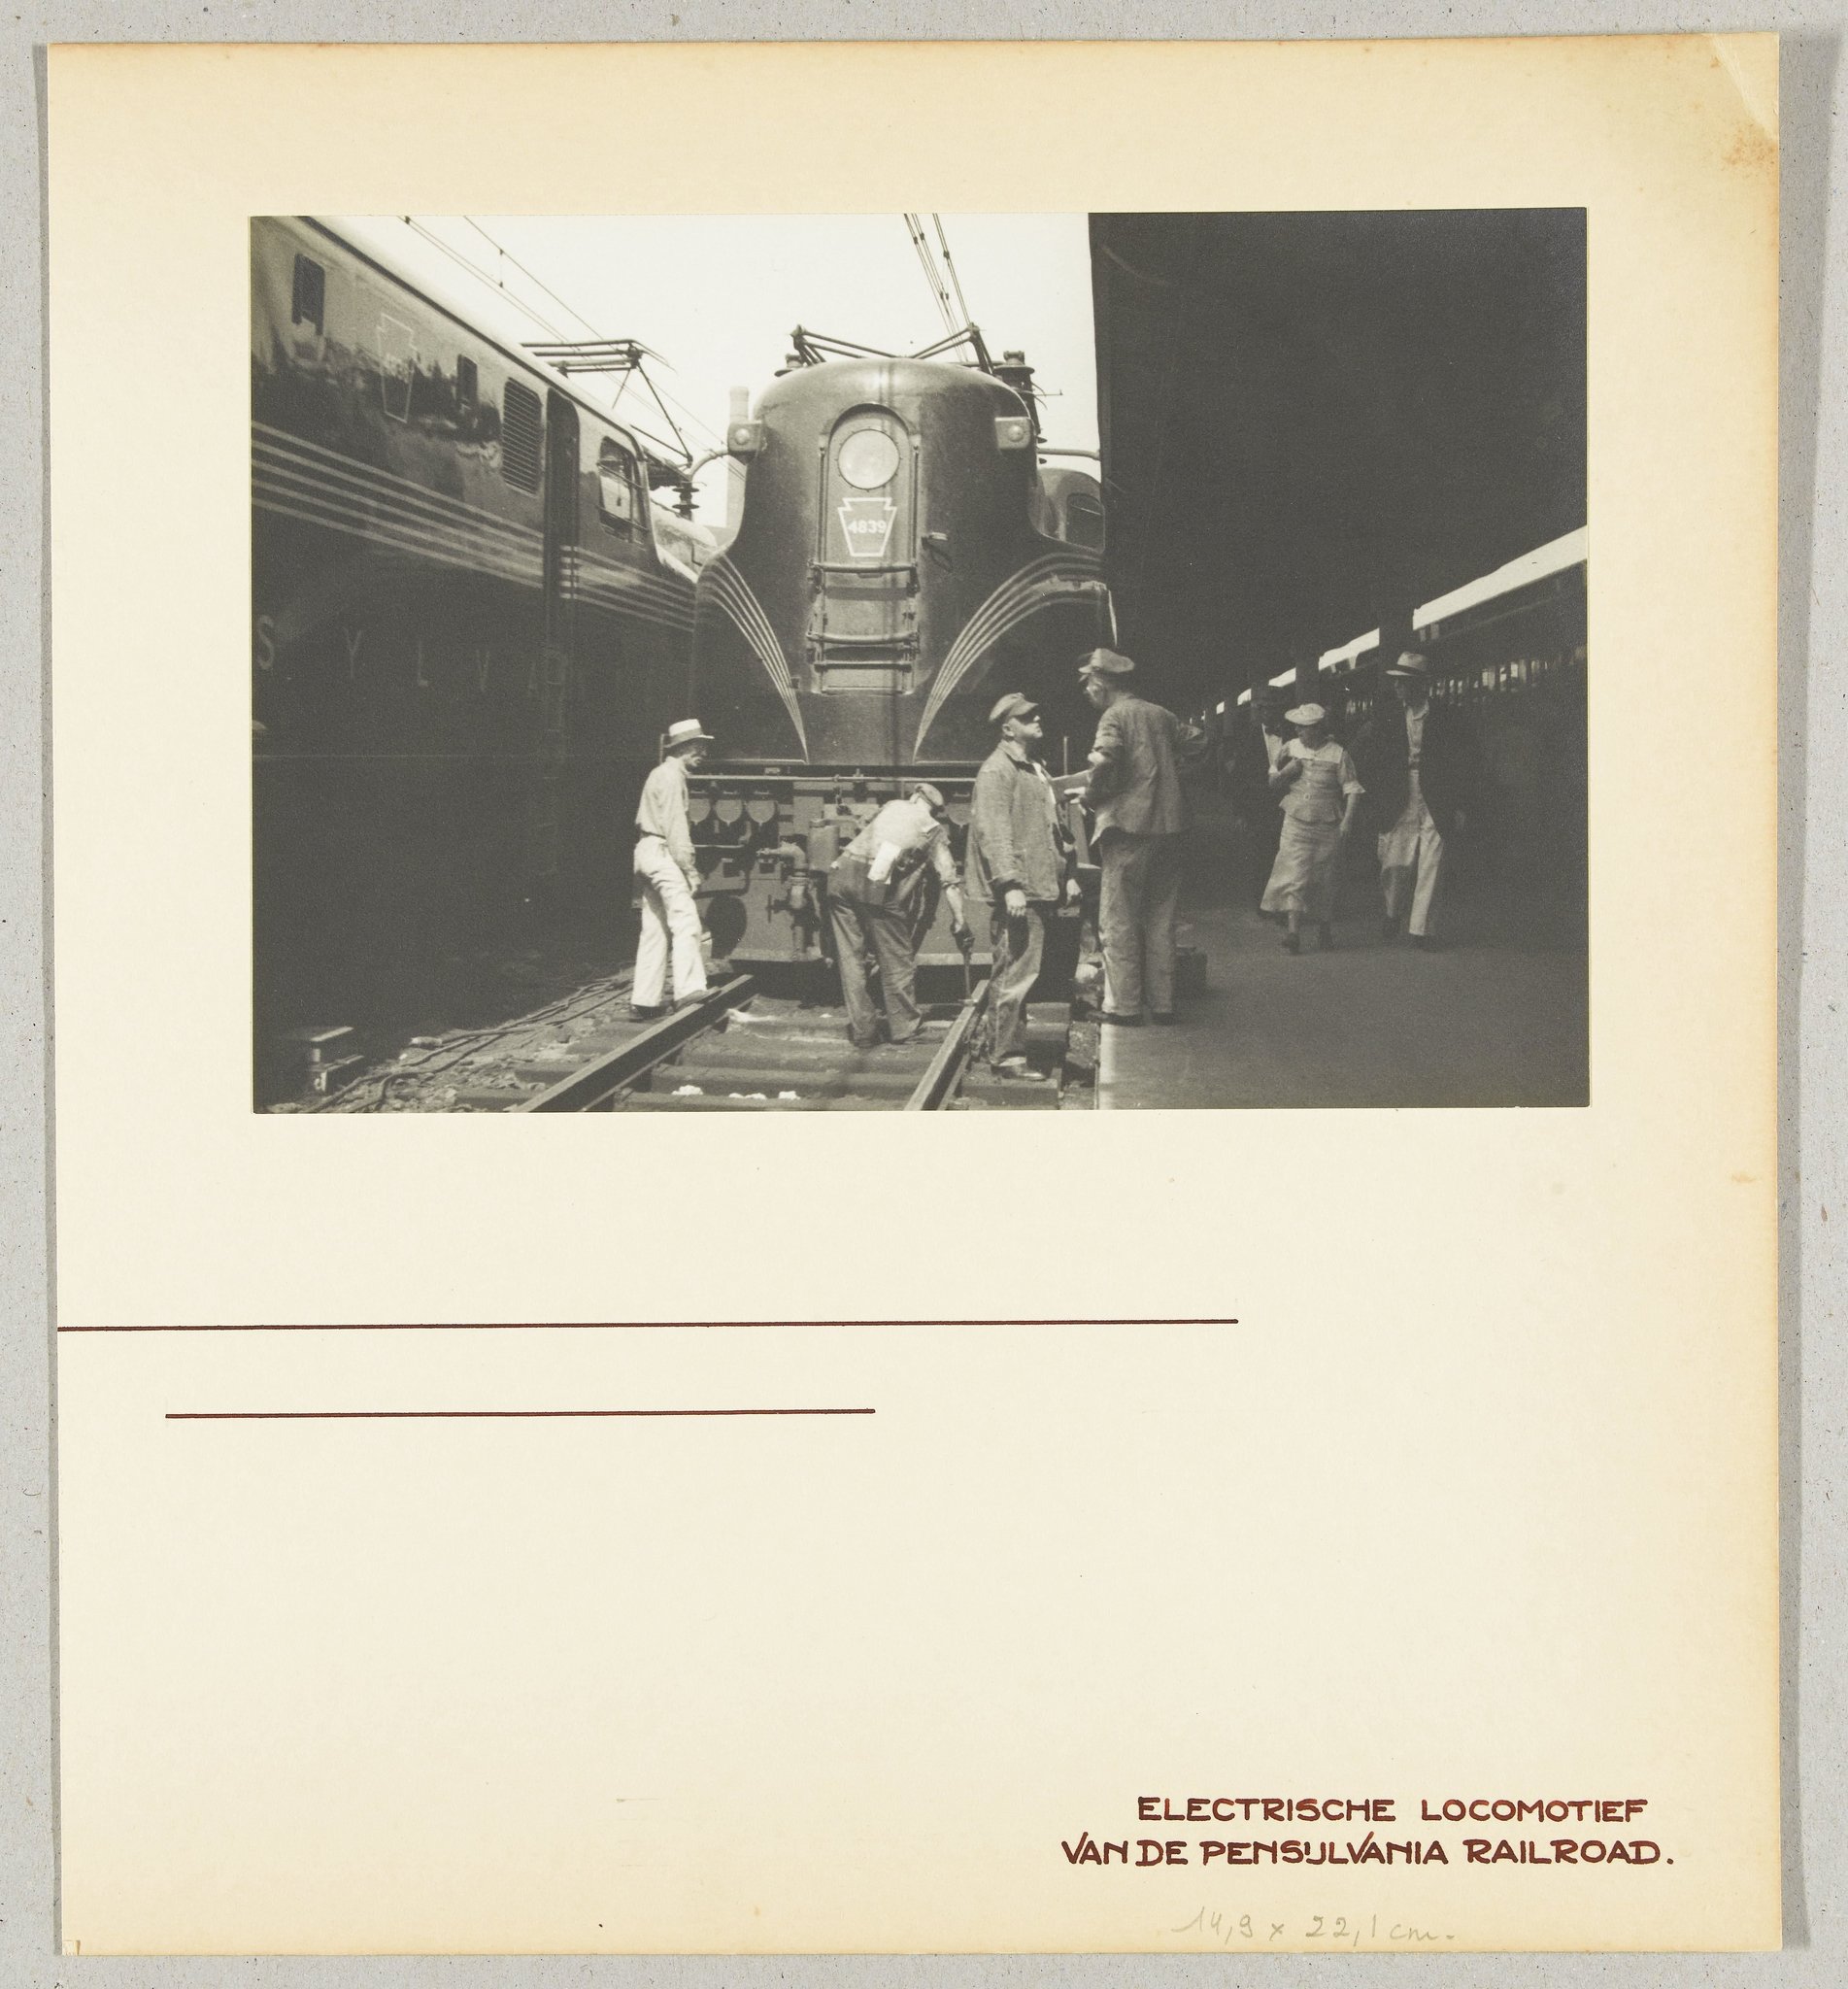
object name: photograph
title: Electrische locomotief van de Pennsylvania Rail Road, Verenigde Staten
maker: wouter cool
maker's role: engineer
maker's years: 1877-1947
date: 1936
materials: cardboard, paper, photographic support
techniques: gelatin silver print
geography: united states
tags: locomotive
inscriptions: title: ‘ELECTRISCHE LOCOMOTIEF / VAN DE PENSIJLVANIA RAILROAD.’